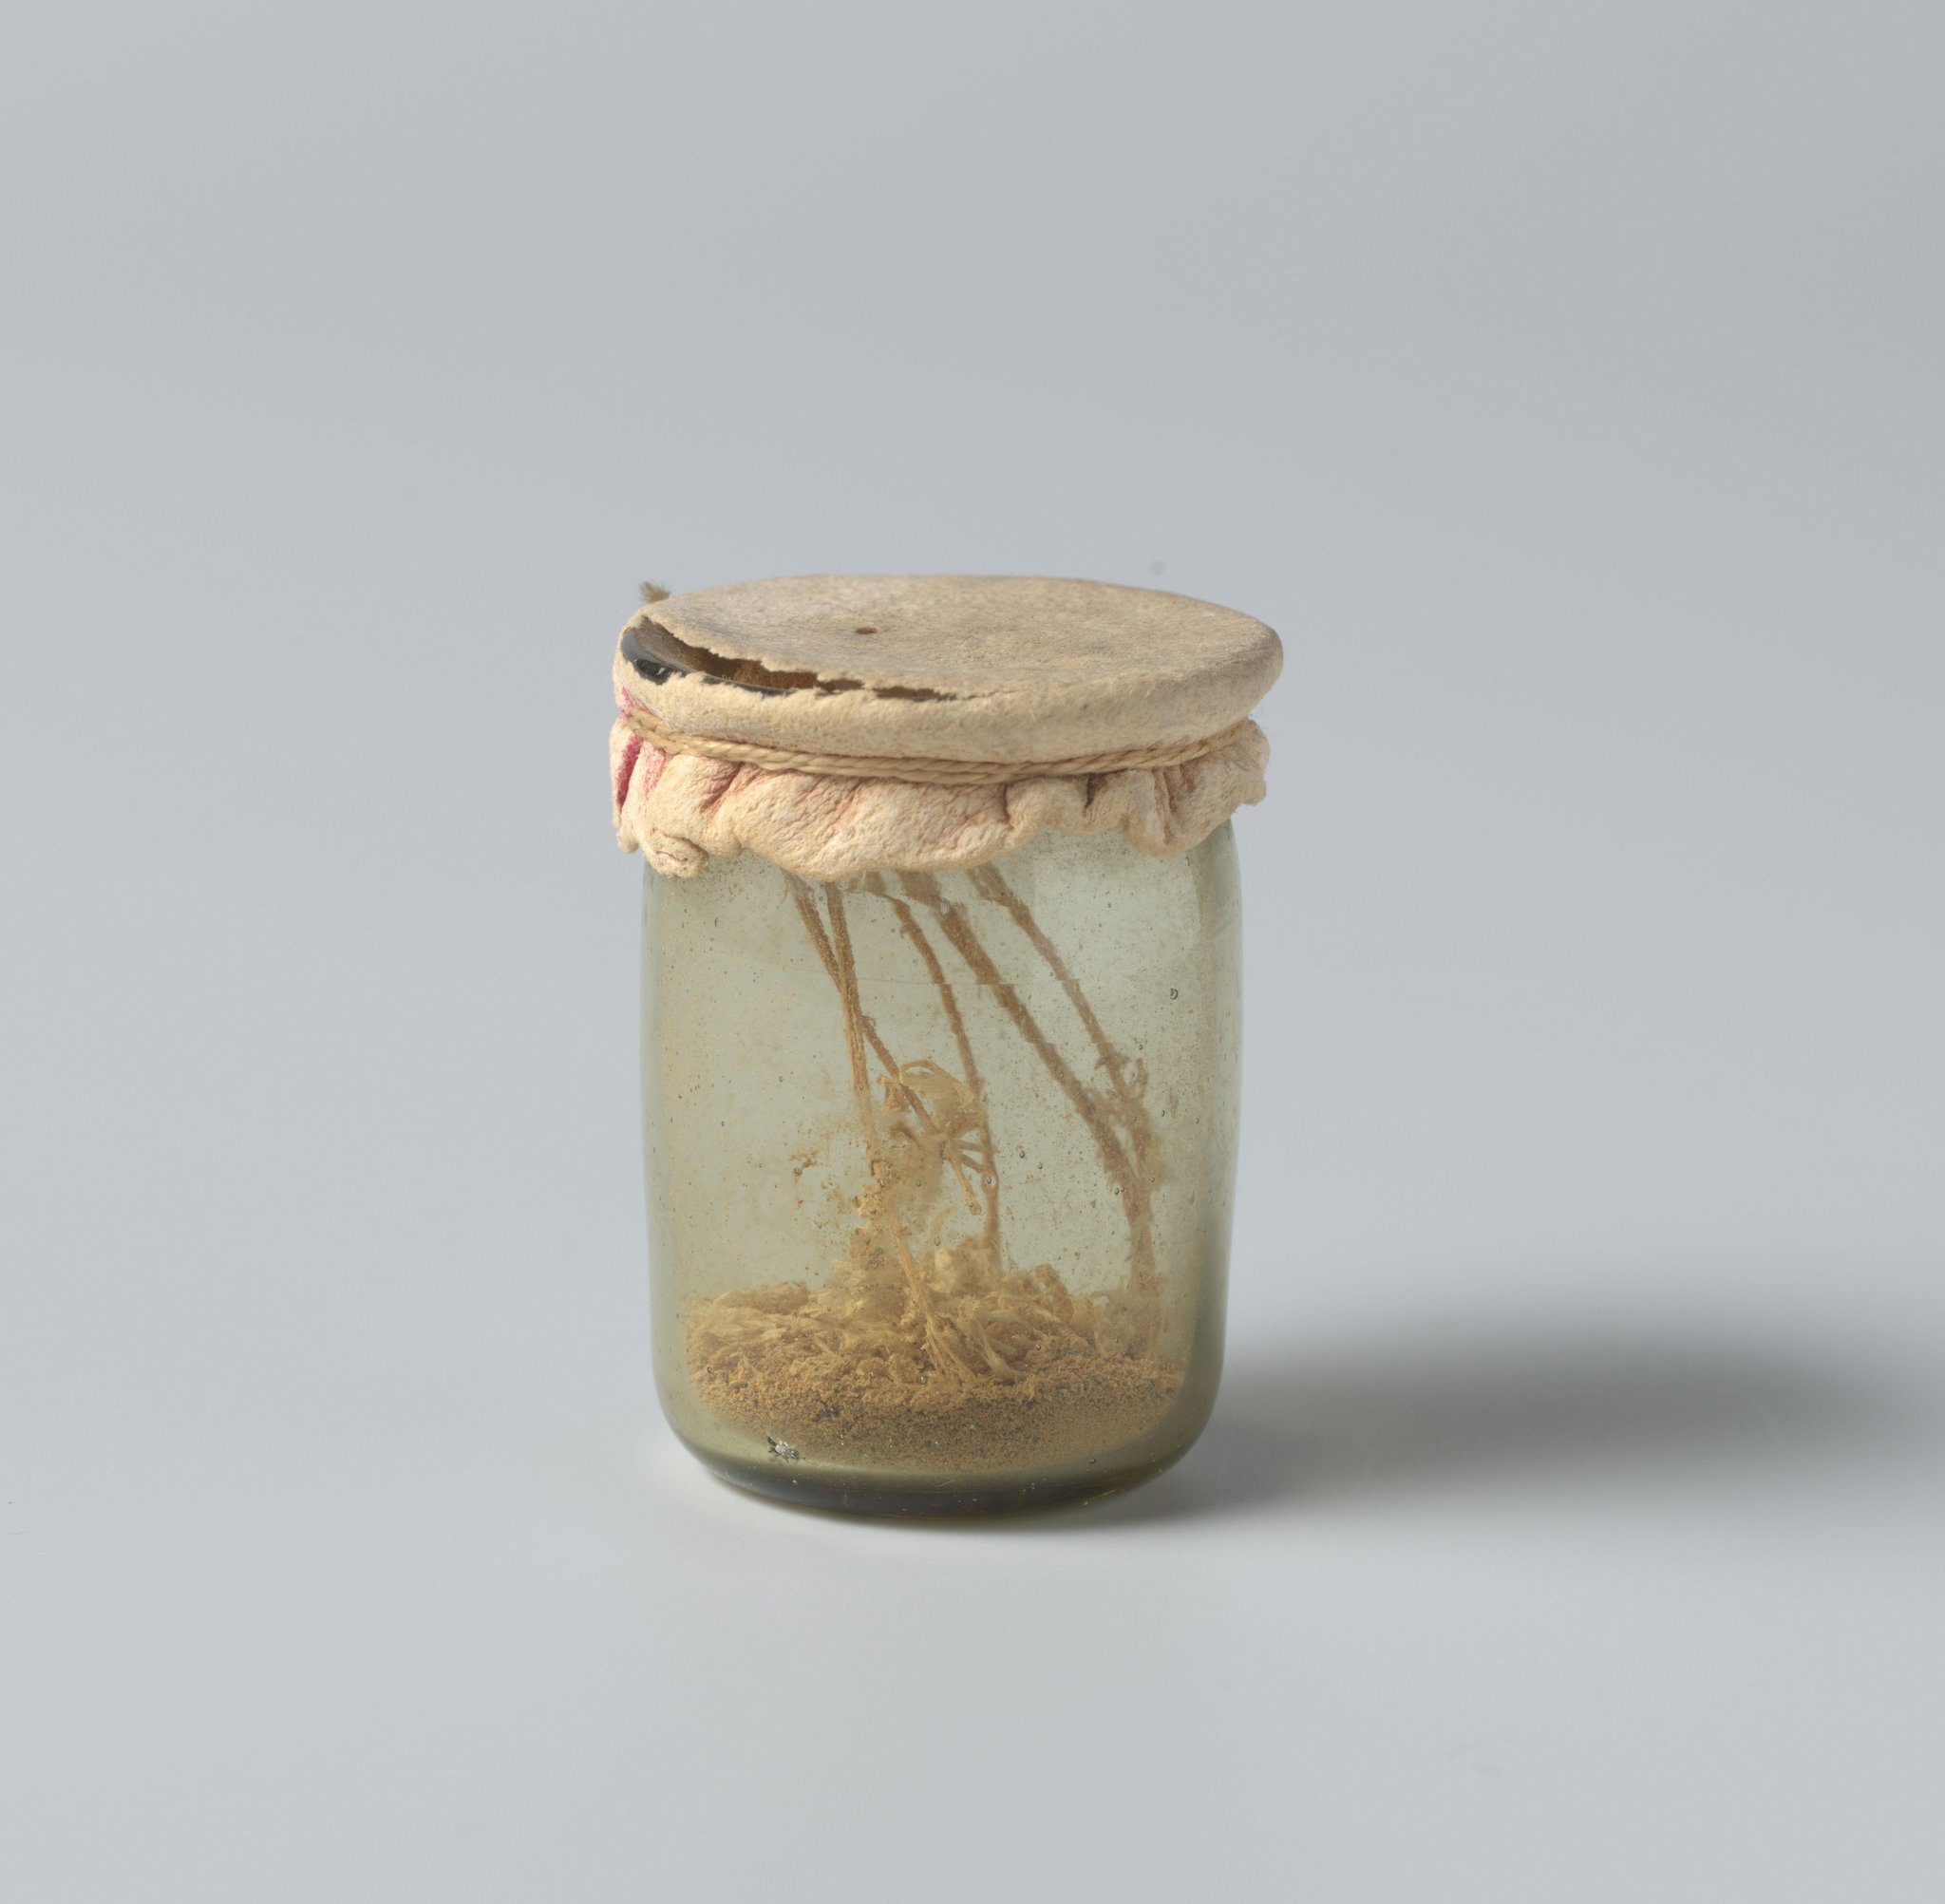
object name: miniature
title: Voorraadpot, cilindervormig, met ingestoken ziel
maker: Anonymous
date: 1700-1799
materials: glass, leather, fiber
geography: netherlands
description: Voorraadpot van helder groen glas, cilindervormig, met enigszins ingestoken ziel, en wijde halsrand en insnoering. Afgesloten door middel van een stuk roze leer, omwonden door touw. De pot is gevuld met een geel poeder en bloemstengels.